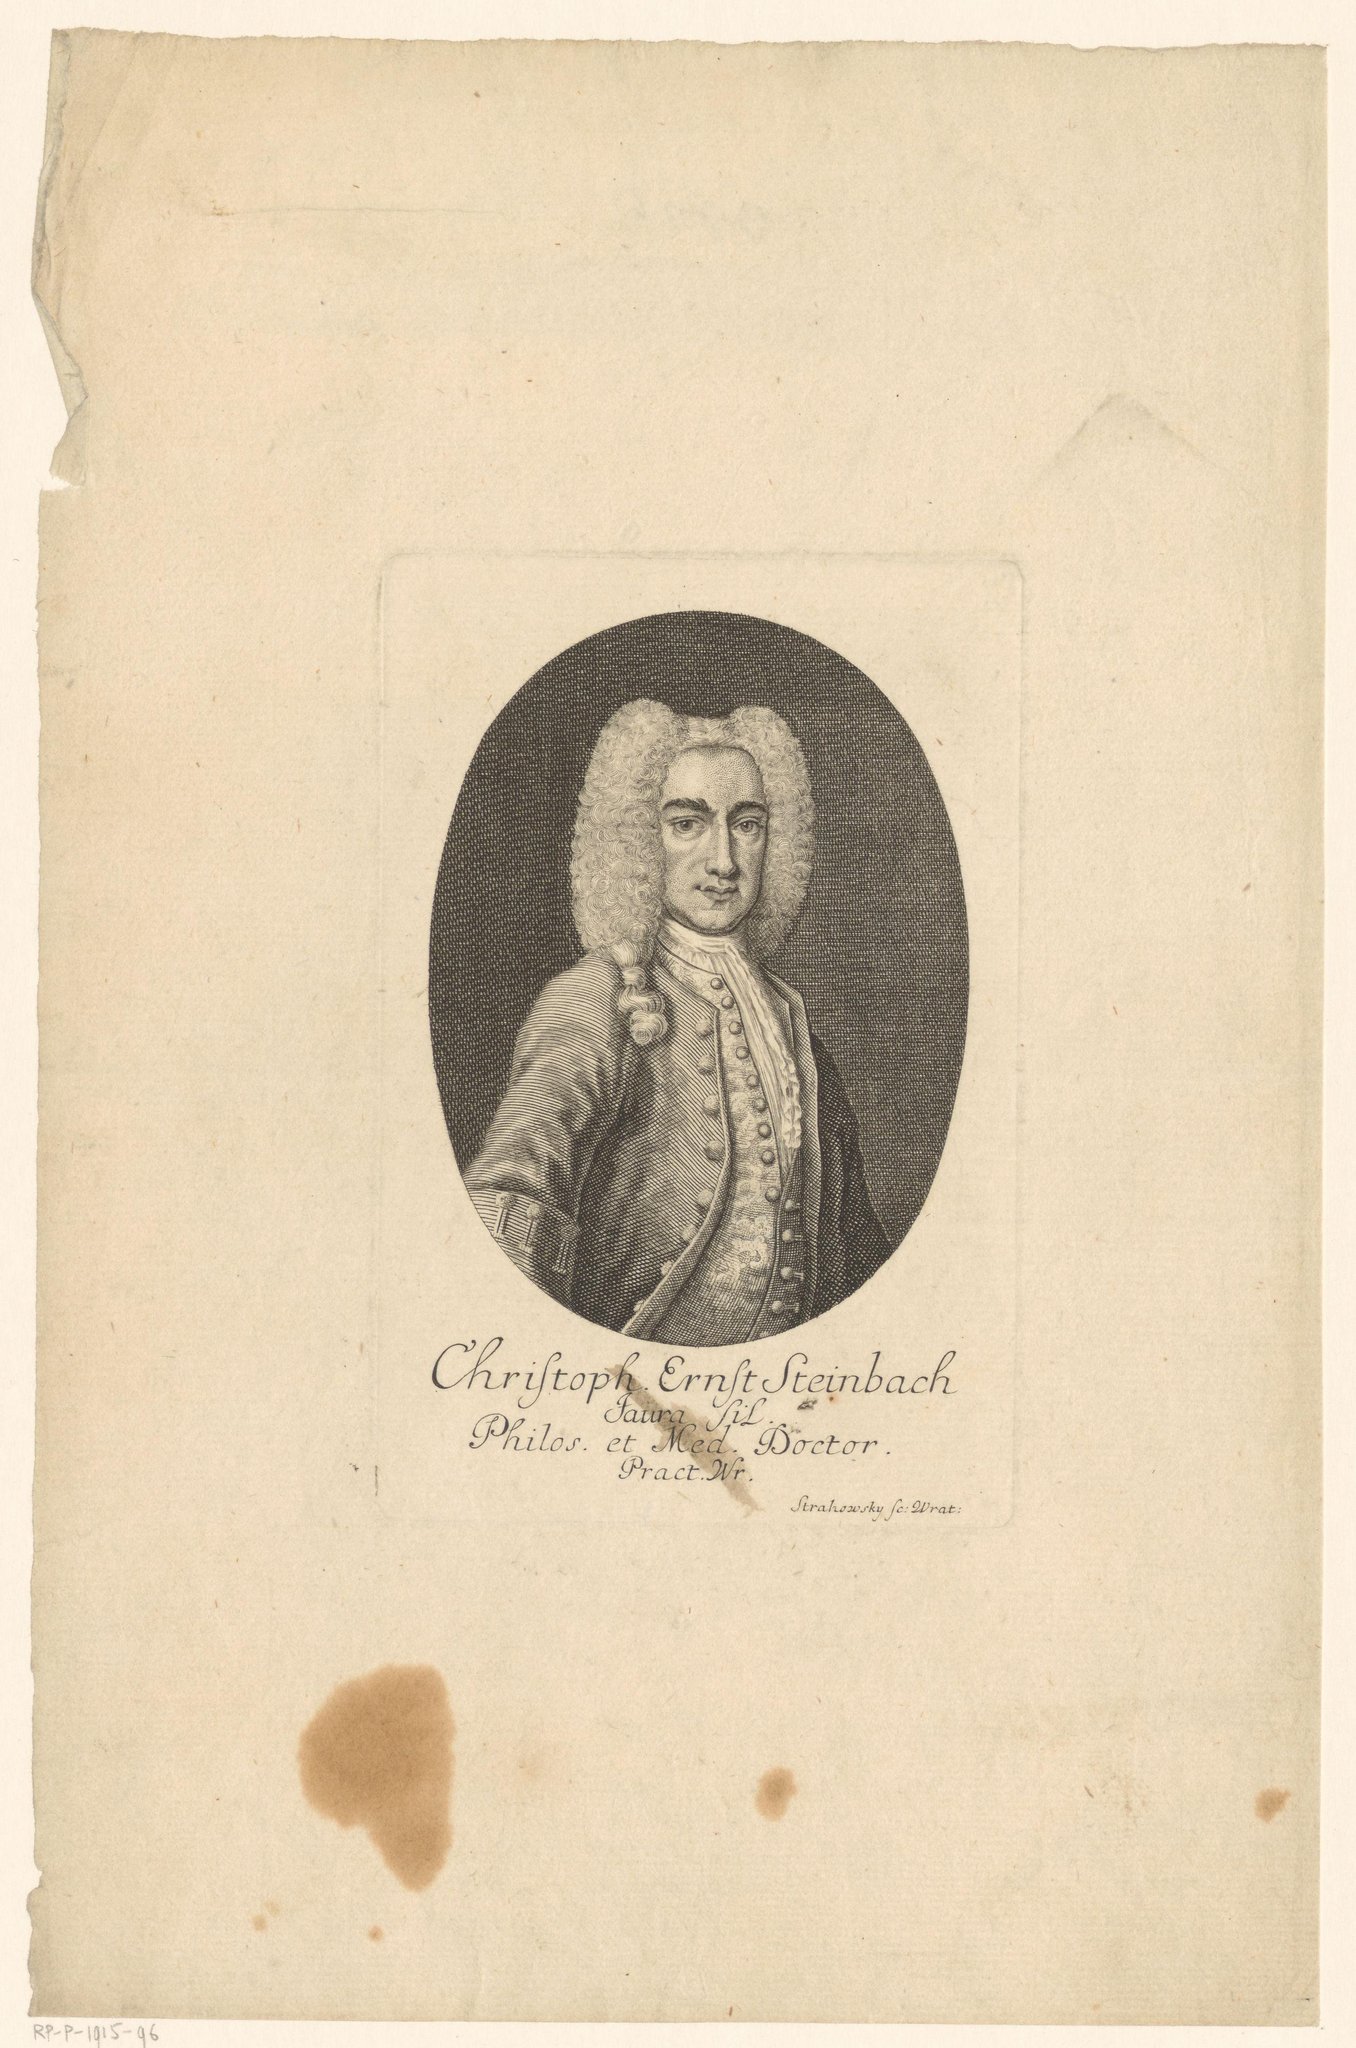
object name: print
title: Portret van Christoph Ernst Steinbach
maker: bartholomäus strahowsky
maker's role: print maker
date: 1724-1759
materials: paper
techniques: engraving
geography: breslau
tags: historical persons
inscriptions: collector's mark: Lugt 2228